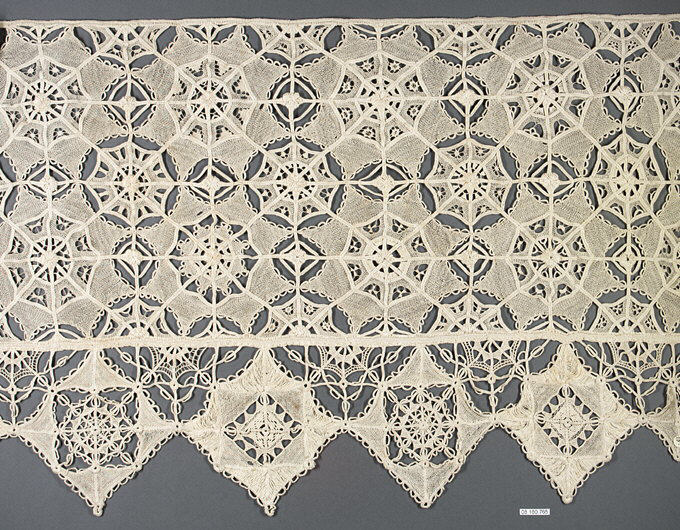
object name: fragment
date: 1801-1900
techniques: lace